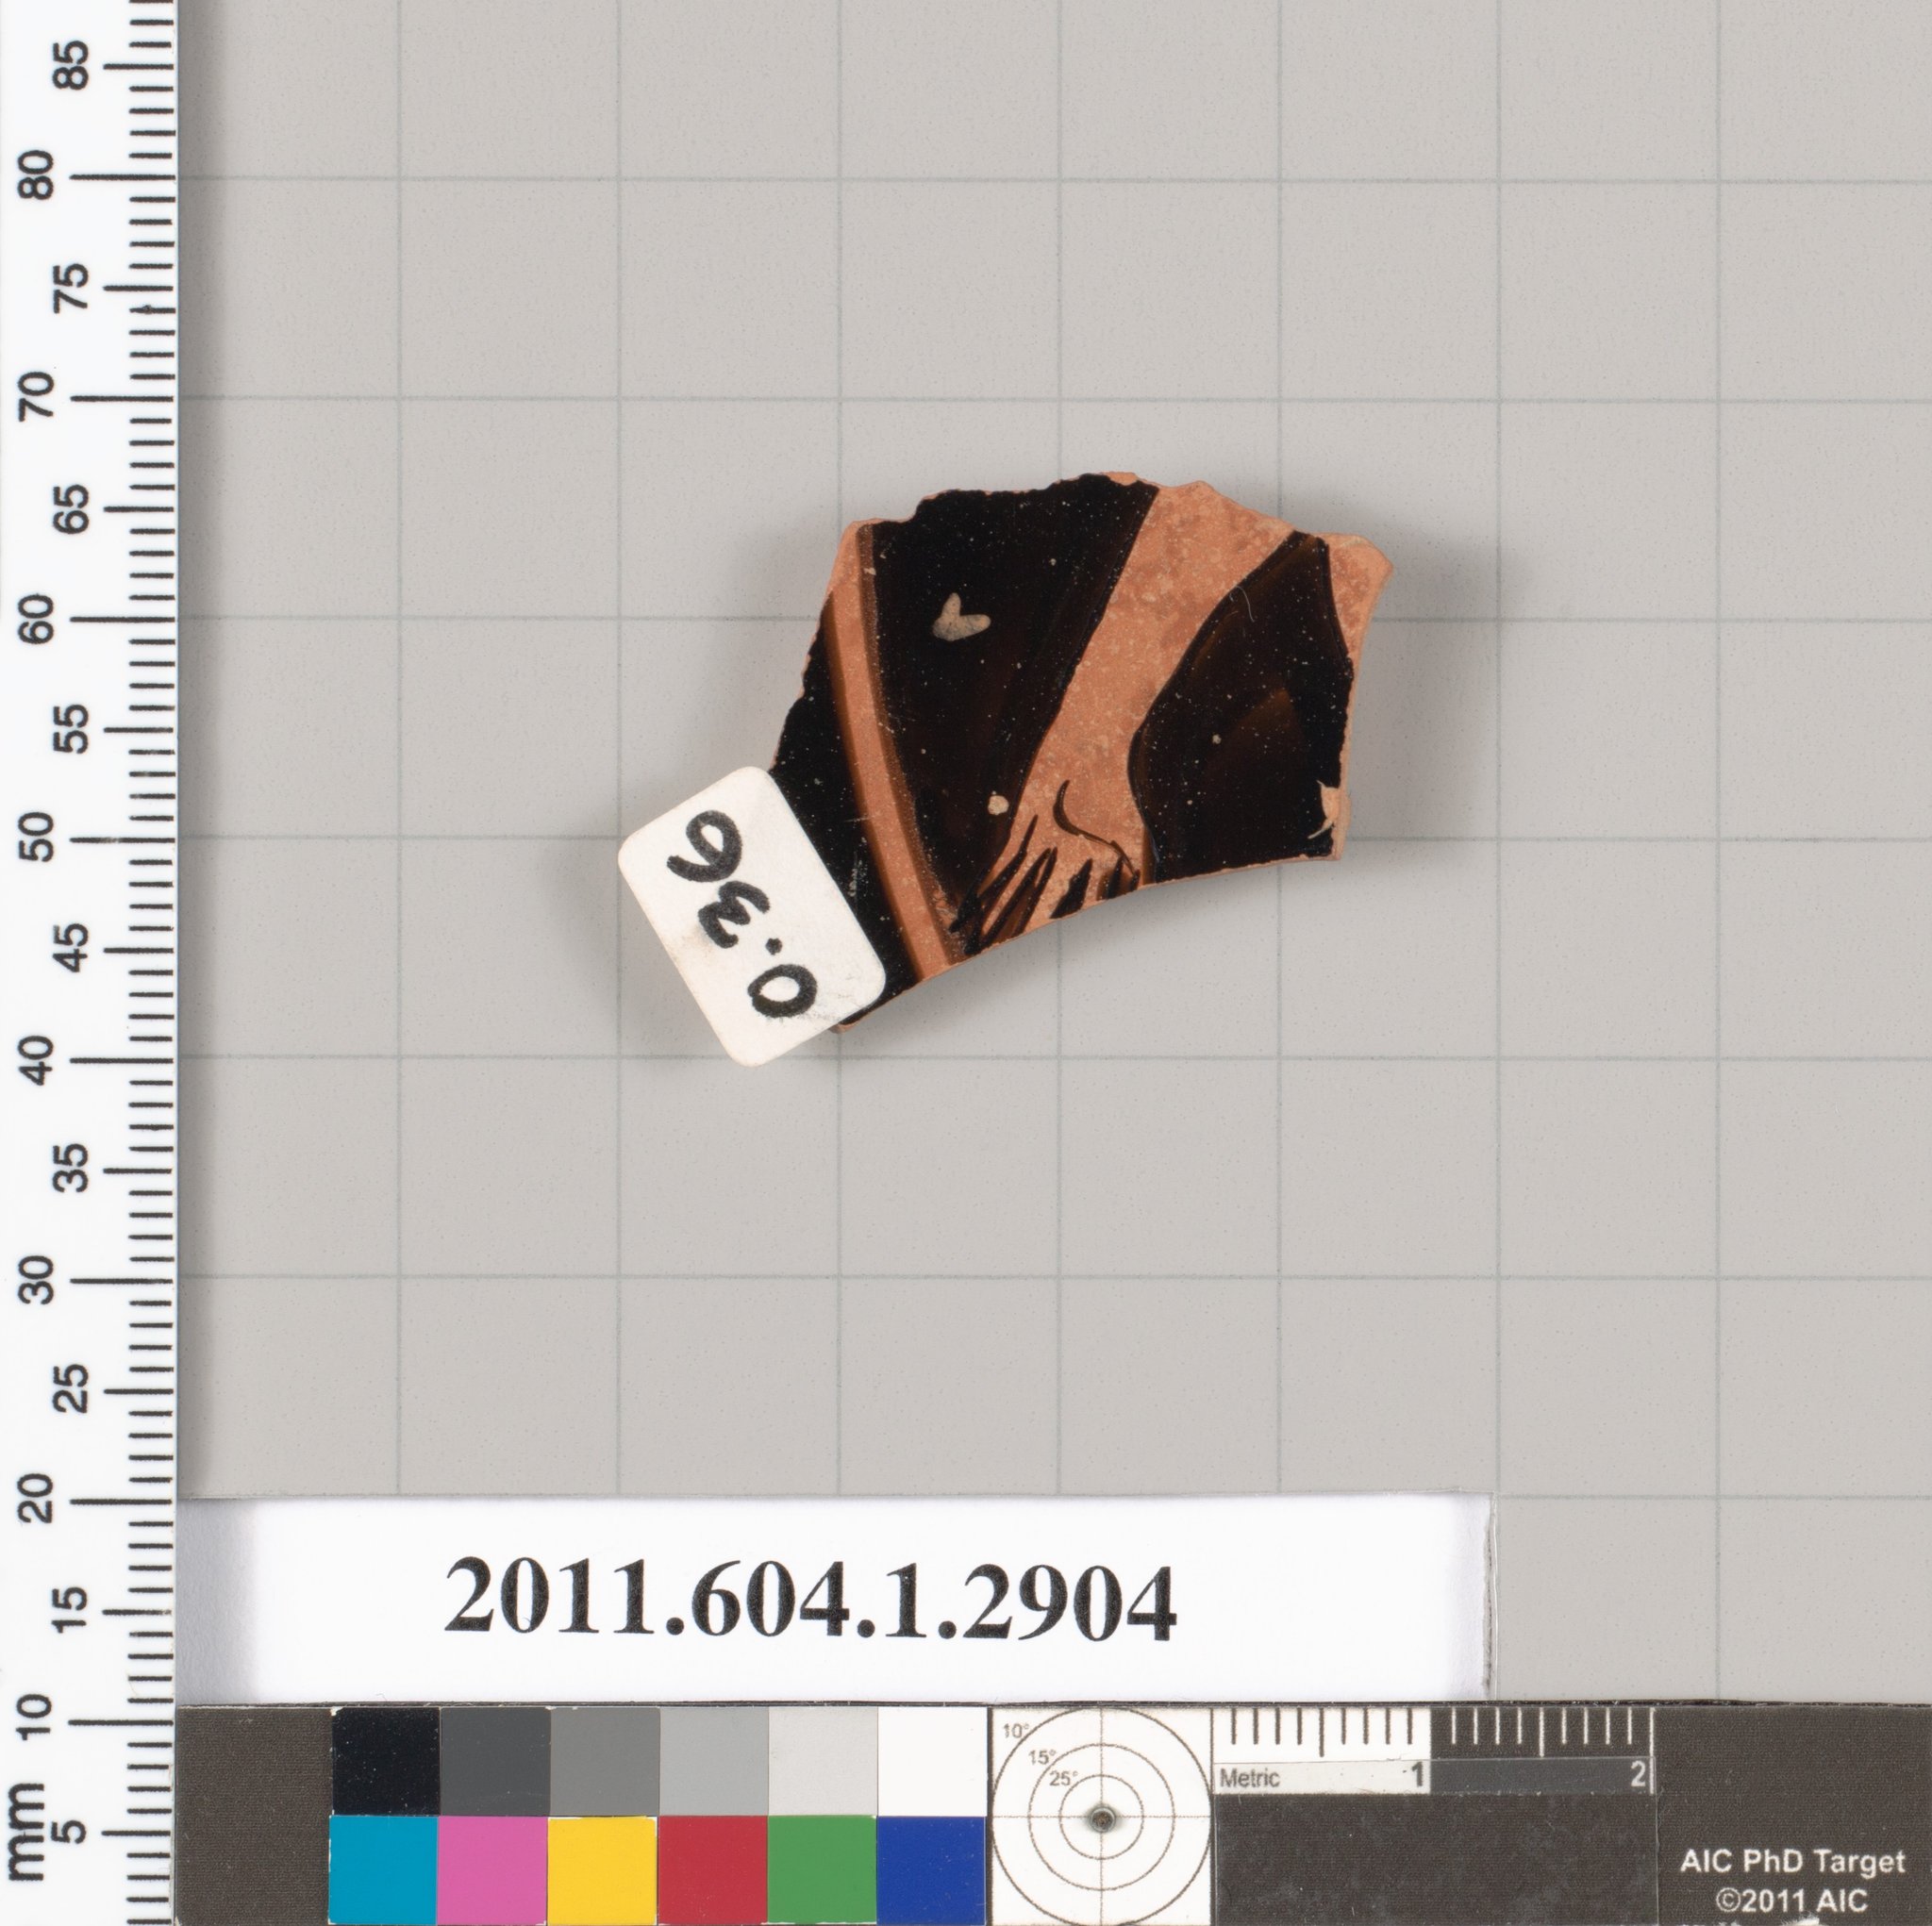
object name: kylix fragment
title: Terracotta fragment of a kylix (drinking cup)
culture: greek, attic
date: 500-480 BCE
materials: terracotta